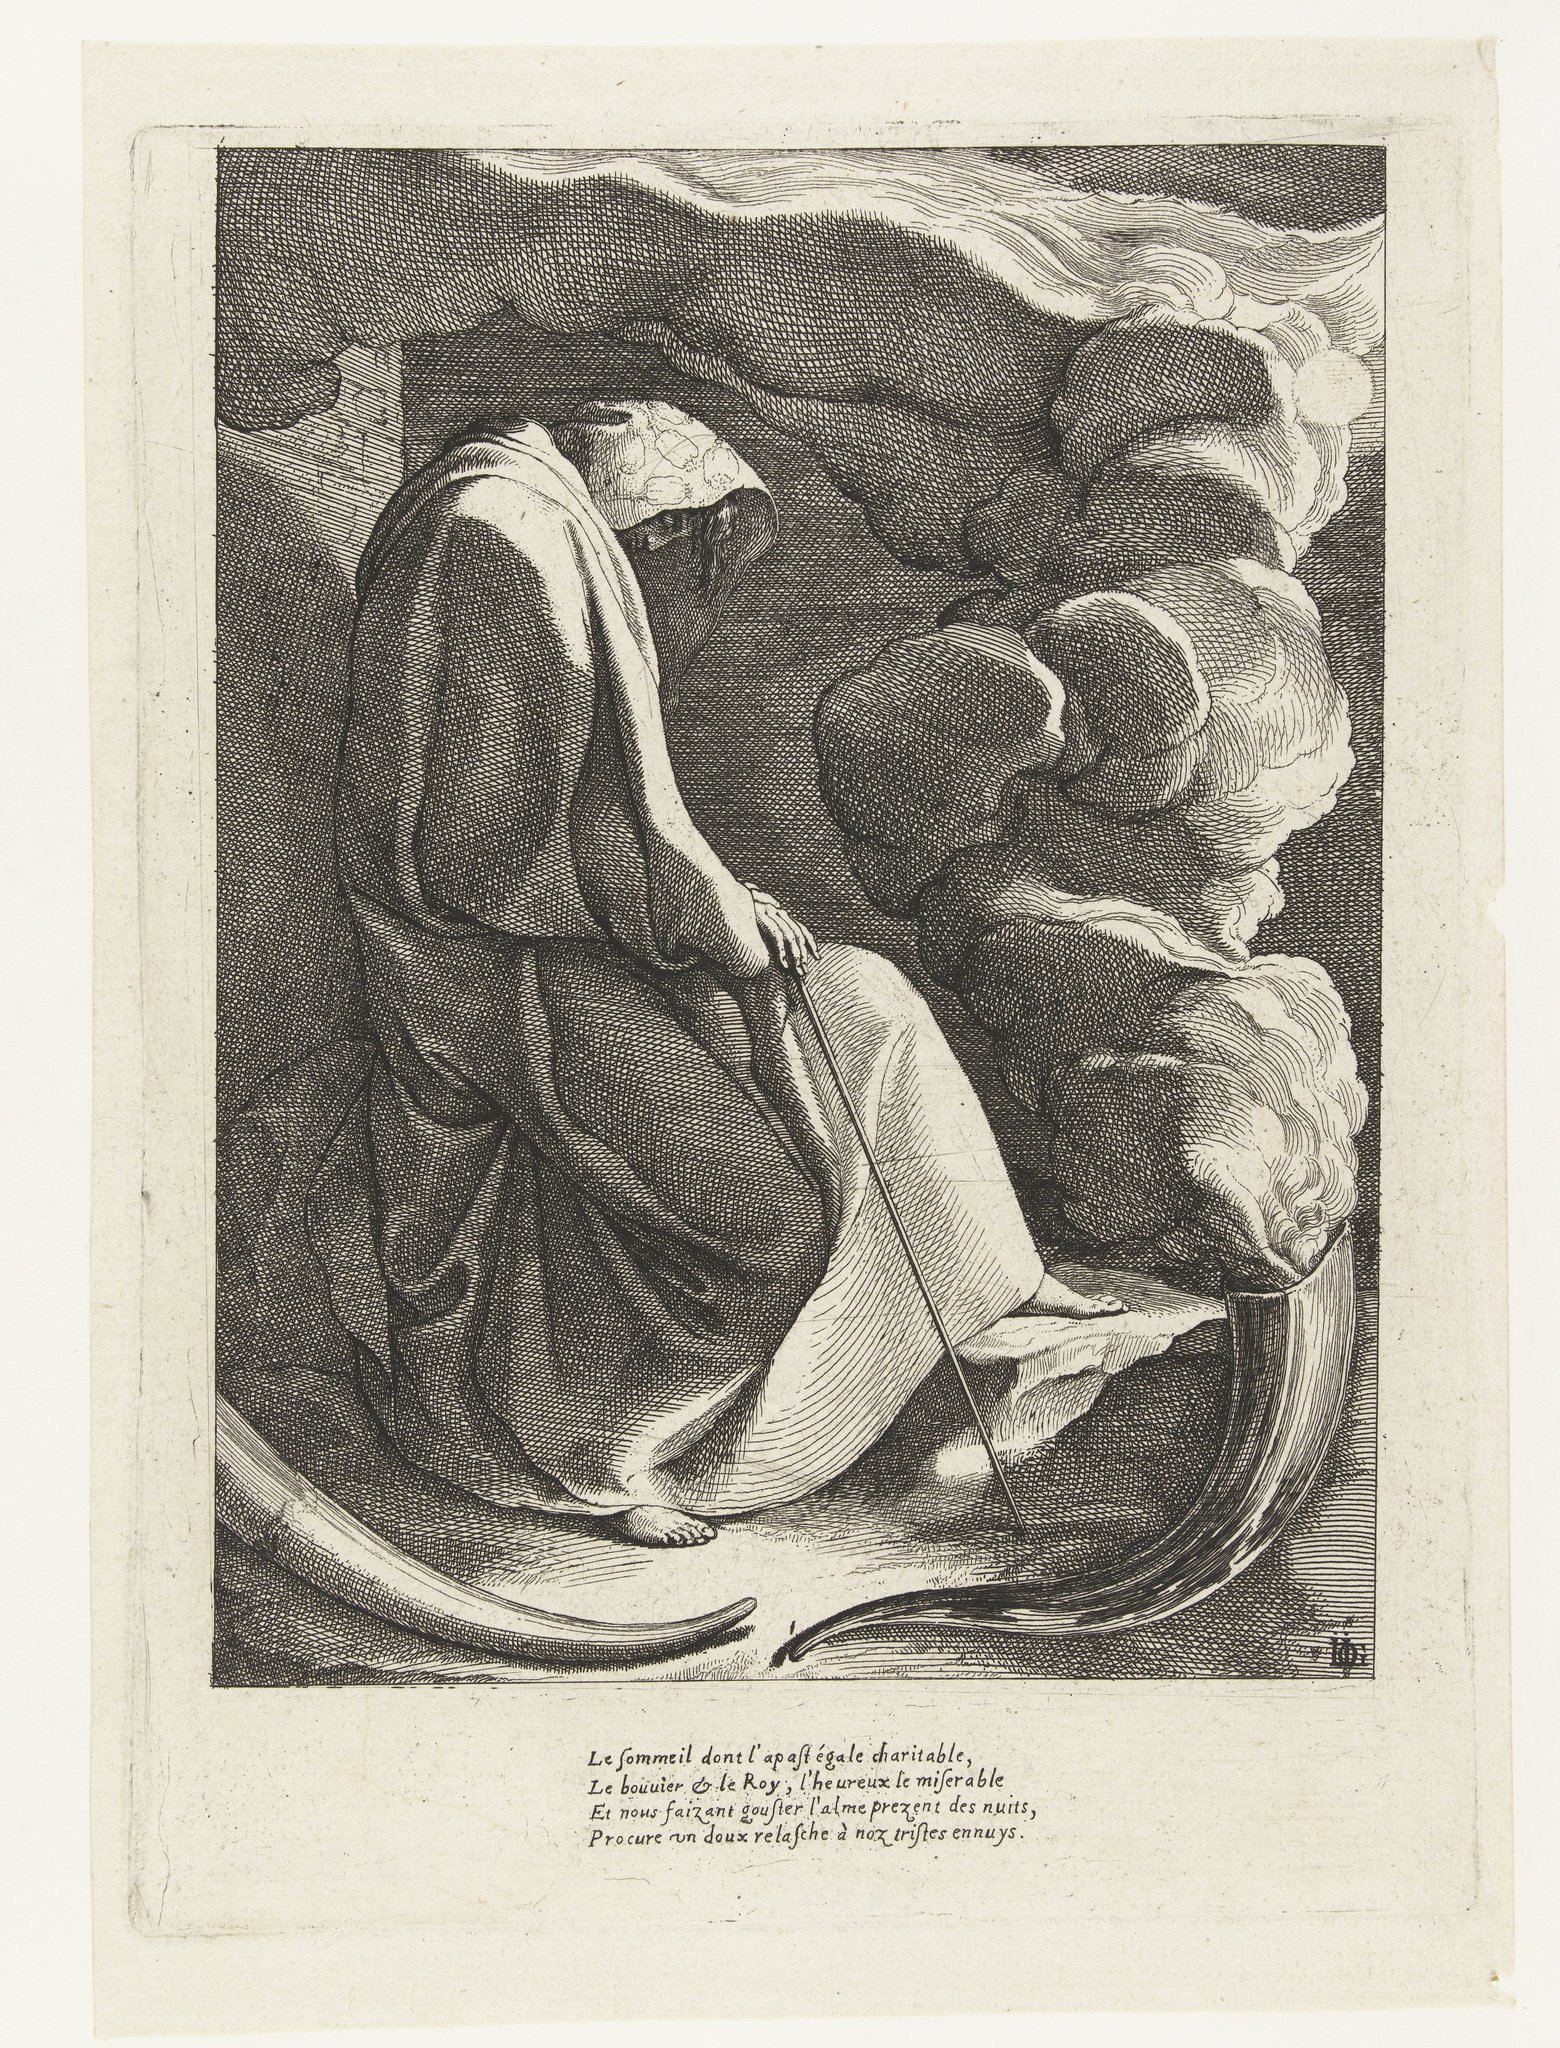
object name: print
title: Slaap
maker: jacques de gheyn (iii)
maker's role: draughtsman, print maker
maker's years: 1596-1644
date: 1606-1624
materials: paper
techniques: etching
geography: netherlands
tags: (story of) hypnos (somnus), sleep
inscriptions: collector's mark: Lugt 2228a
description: De slaap in de gedaante van een slapende figuur in een mantel met papavers op de capuchon, half gezeten leunend tegen een muur, een staf of wandelstok in de handen. Voor de voeten van deze figuur ligt een hoorn waaruit dikke rookwolken verschijnen. Onder de voorstelling een vierregelig gedicht in het Frans.